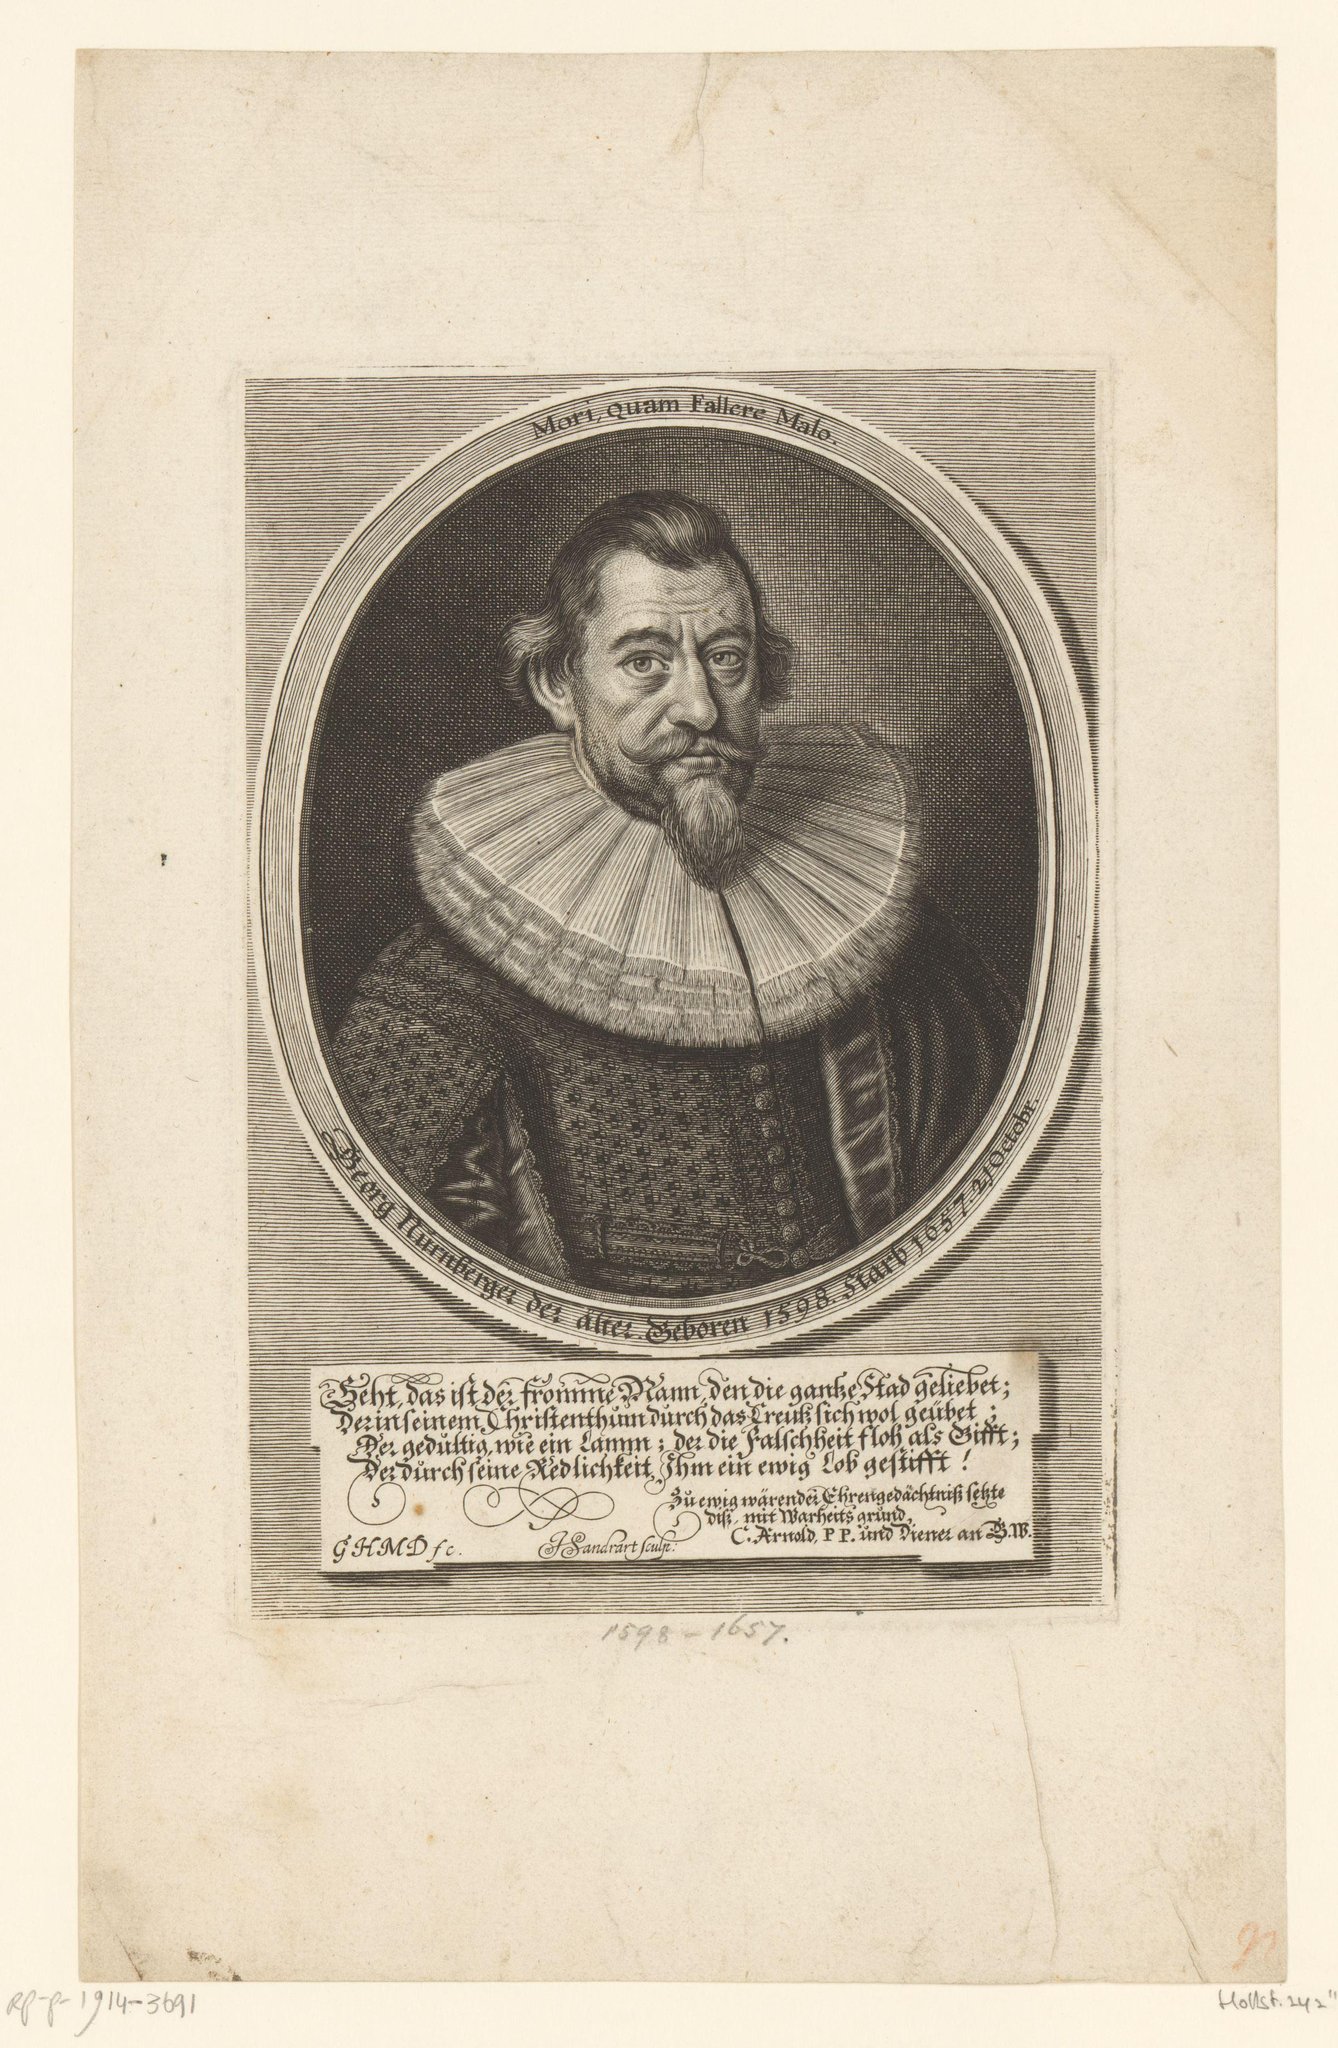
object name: print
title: Portret van Georg Nürnberger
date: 1657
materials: paper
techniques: engraving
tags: historical persons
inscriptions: collector's mark: Lugt 2228